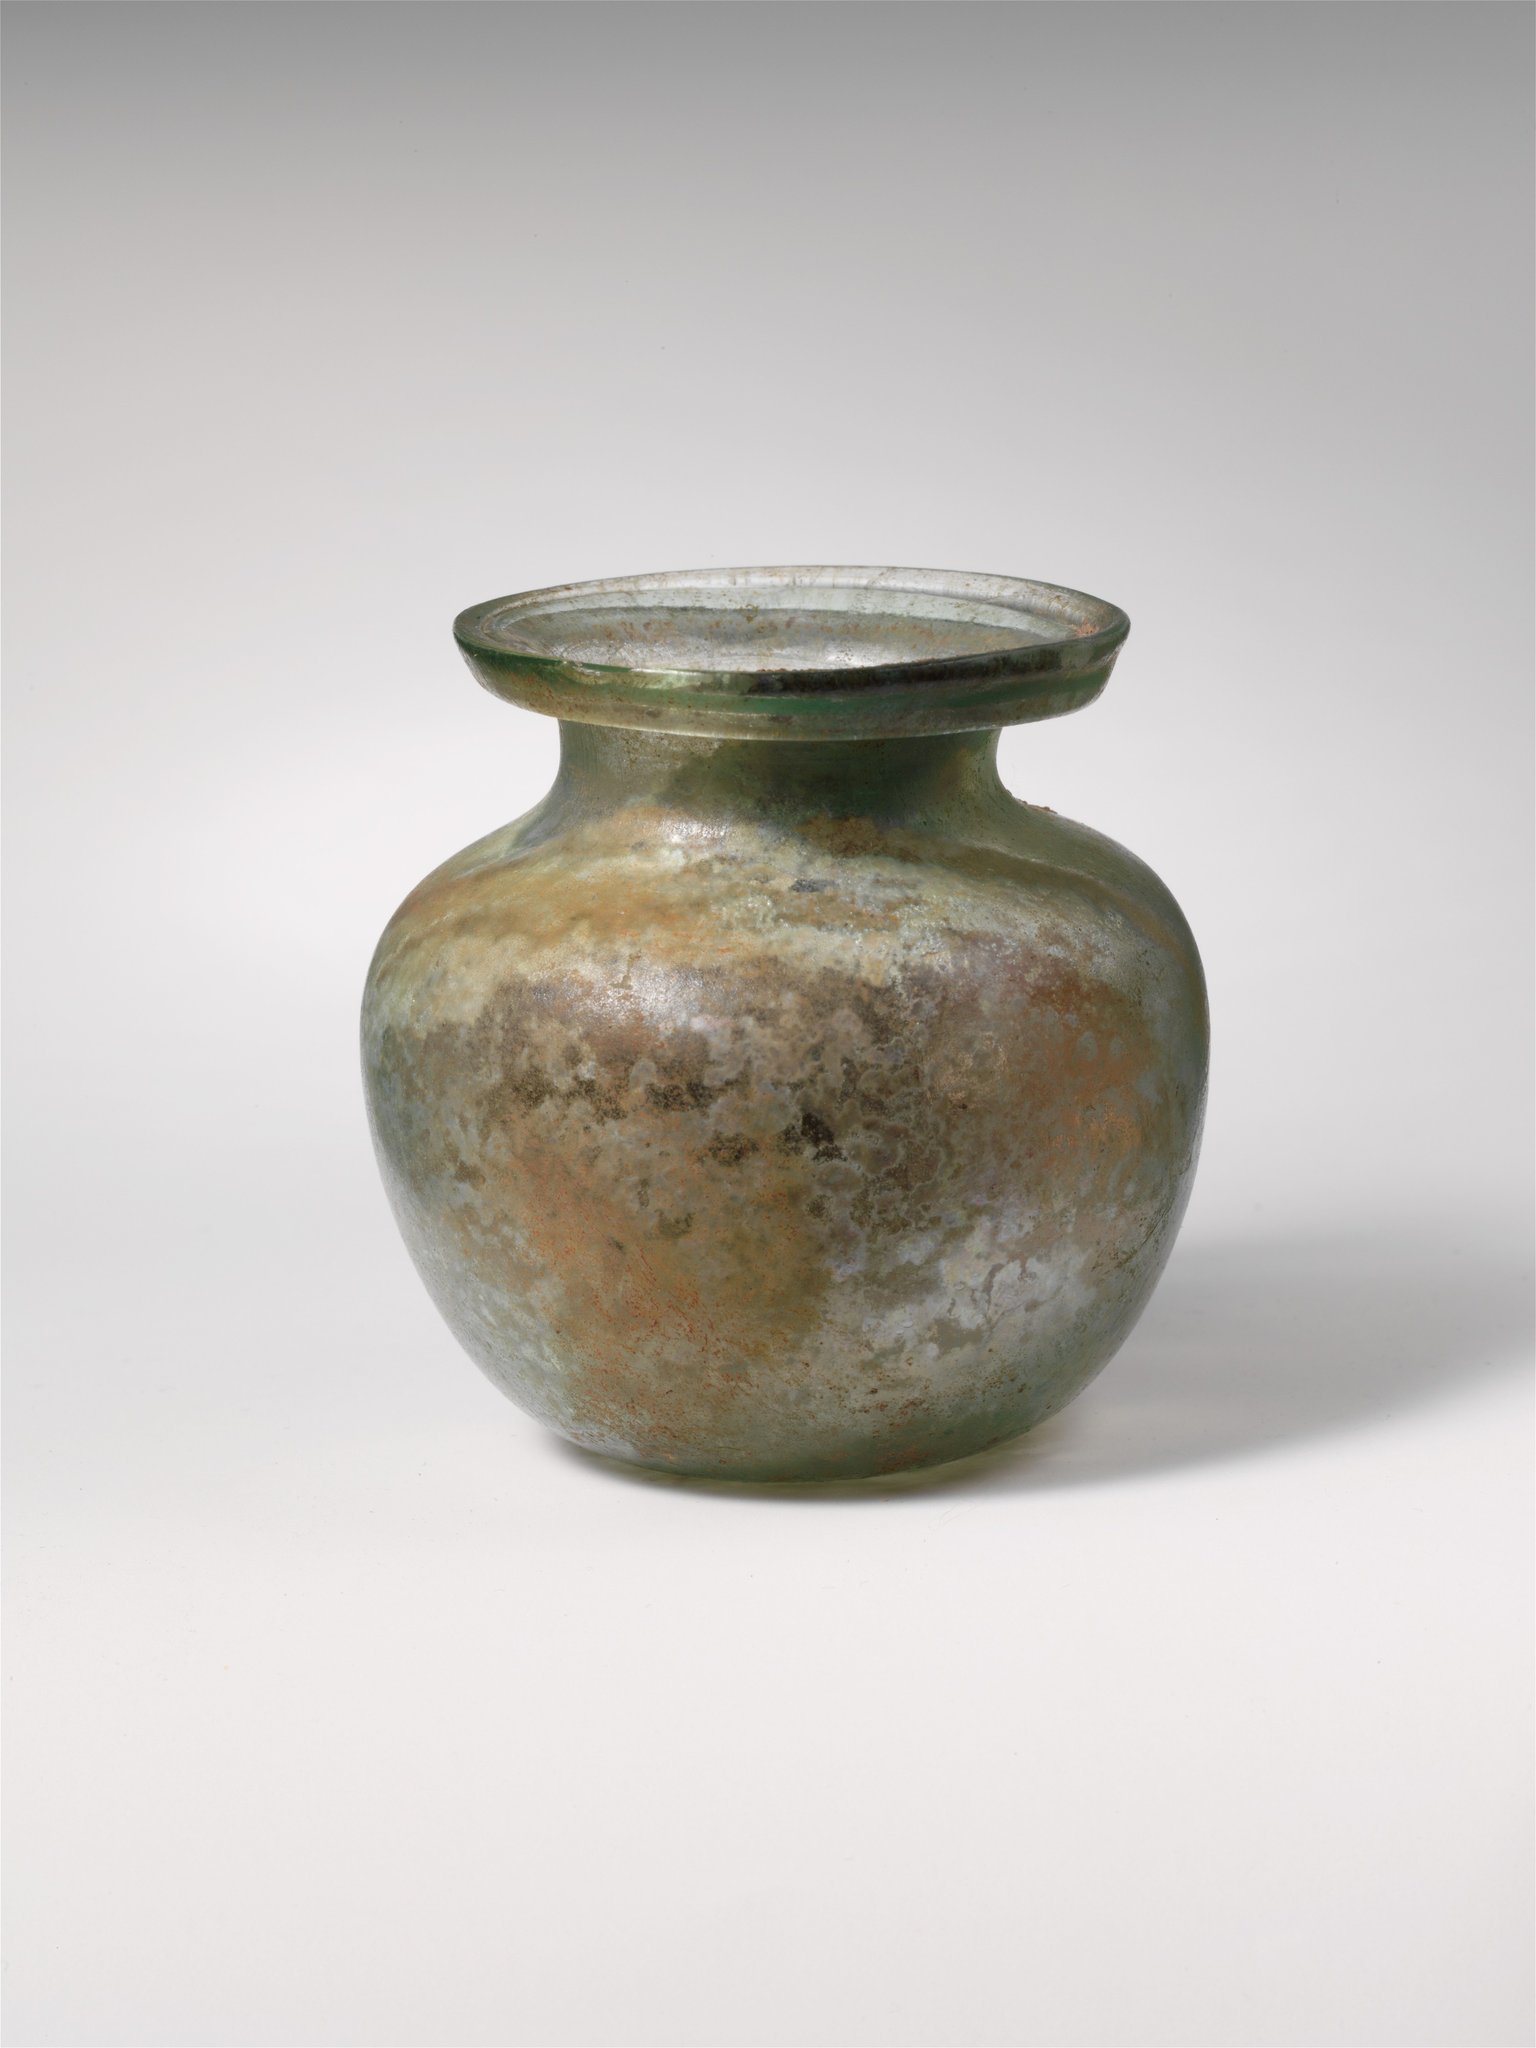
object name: jar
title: Glass jar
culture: roman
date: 101-300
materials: glass